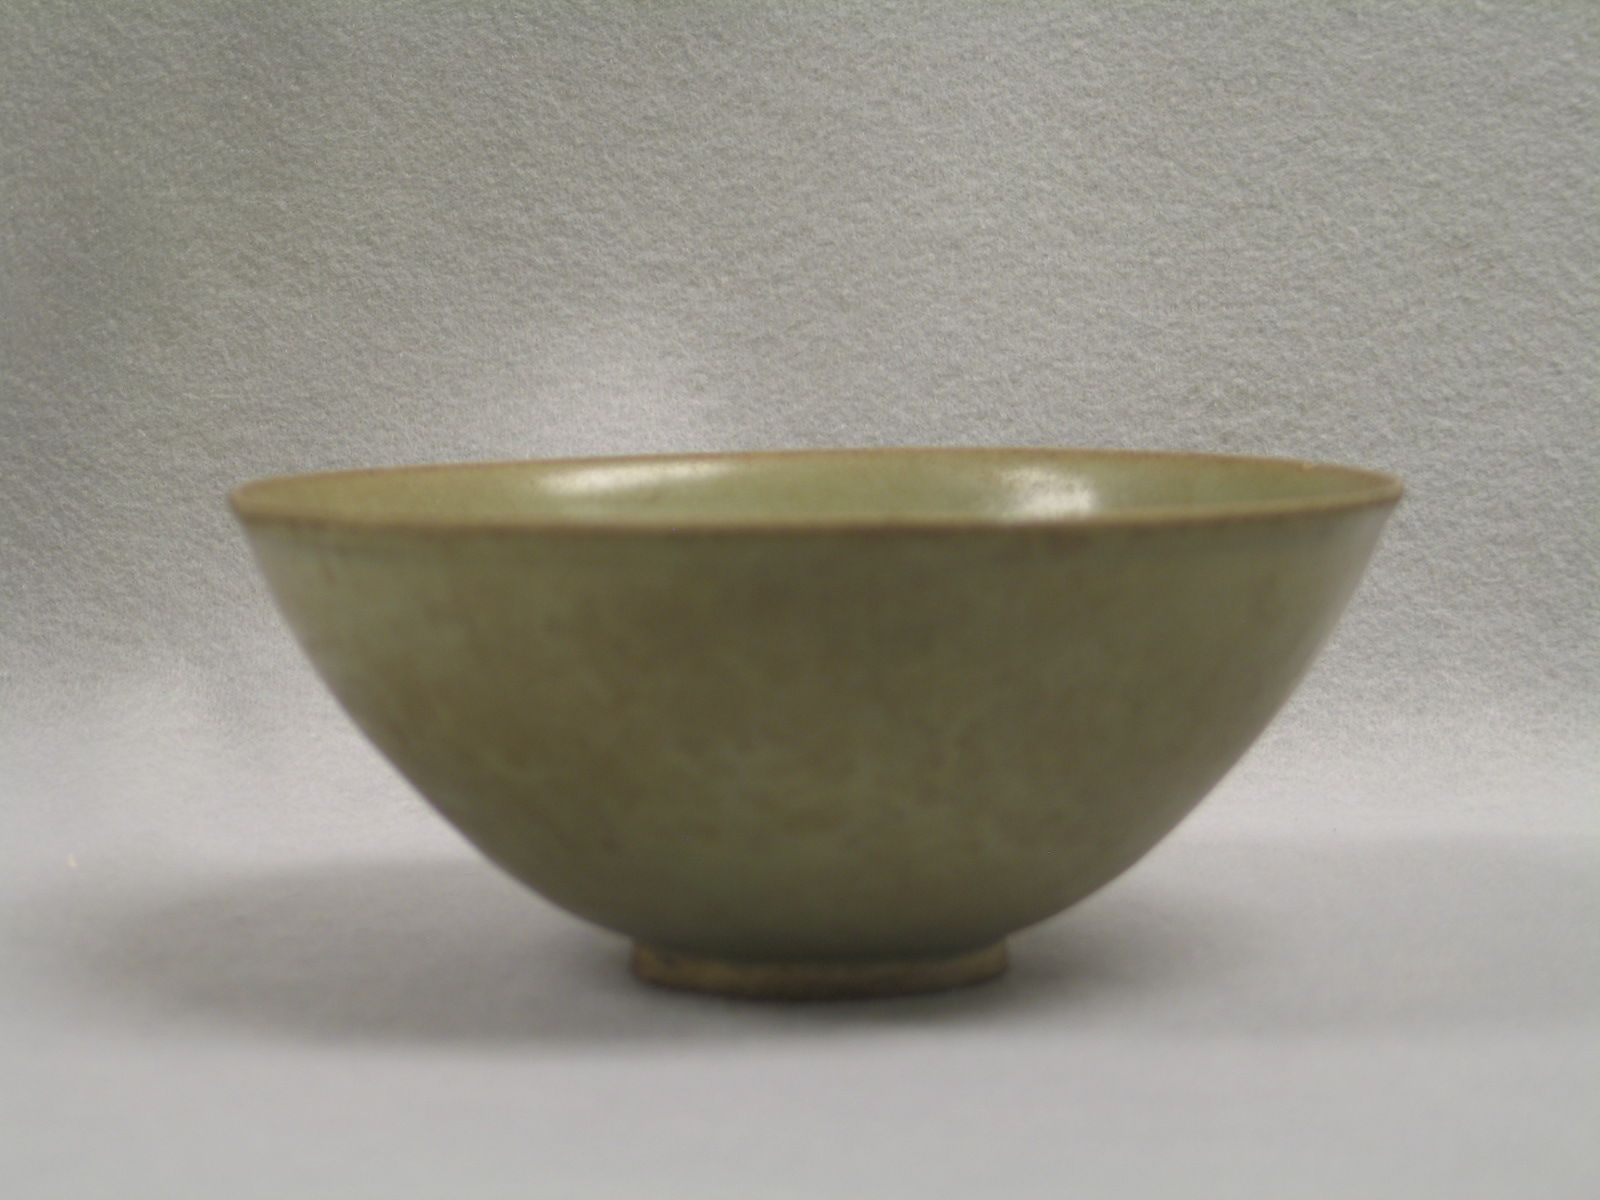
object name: bowl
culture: chinese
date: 1271-1368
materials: glaze, stoneware